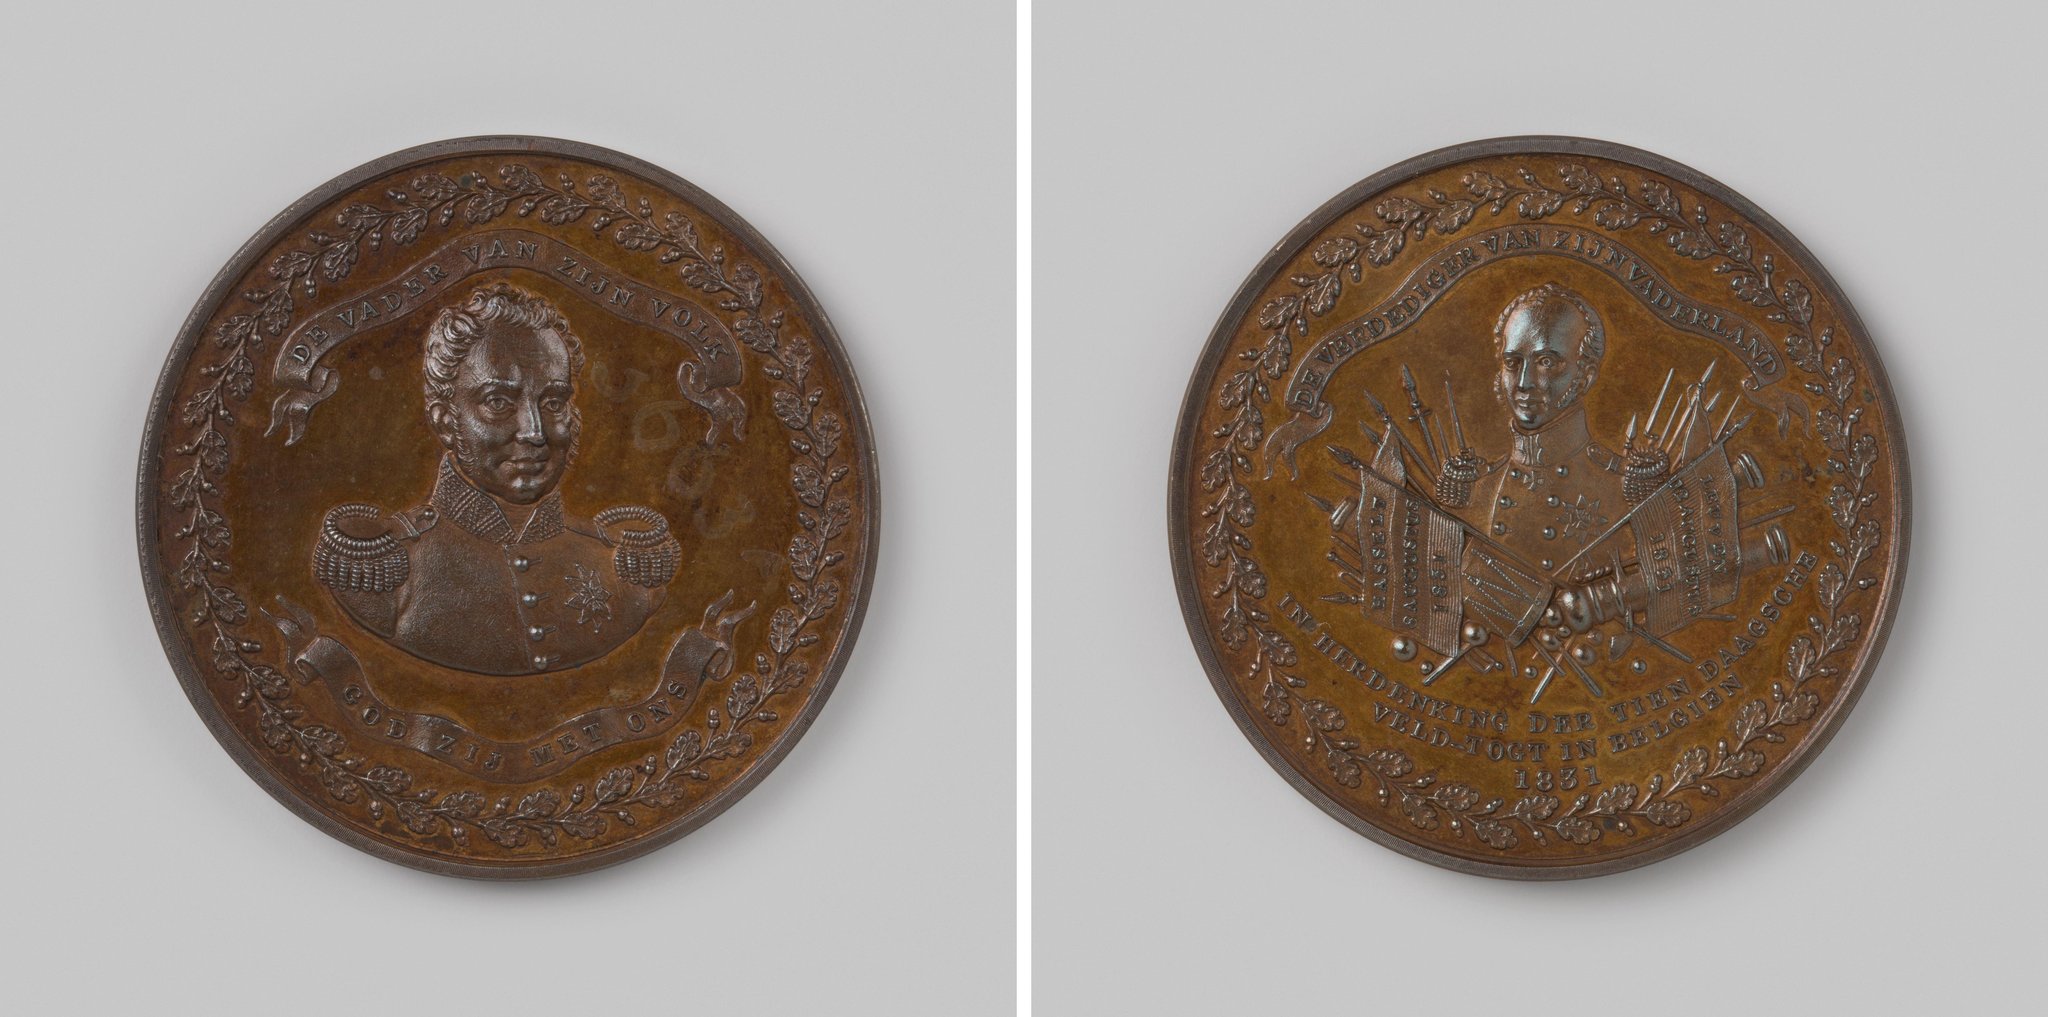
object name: history medal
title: Tiendaagse veldtocht, ter ere van Willem I Frederik, koning der Nederlandenen de kroonprins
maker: Anonymous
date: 1831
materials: bronze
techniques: striking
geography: netherlands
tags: the hague, berlin, william i of the netherlands, william ii of the netherlands, belgium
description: Bronzen penning. Voorzijde: borststuk man onder en boven wimpel met opschrift binnen eikenkrans. Keerzijde: borststuk man temidden van wapentuig en vaandels onder boven wimpel met opschrift binnen omschrift en eikenkrans.